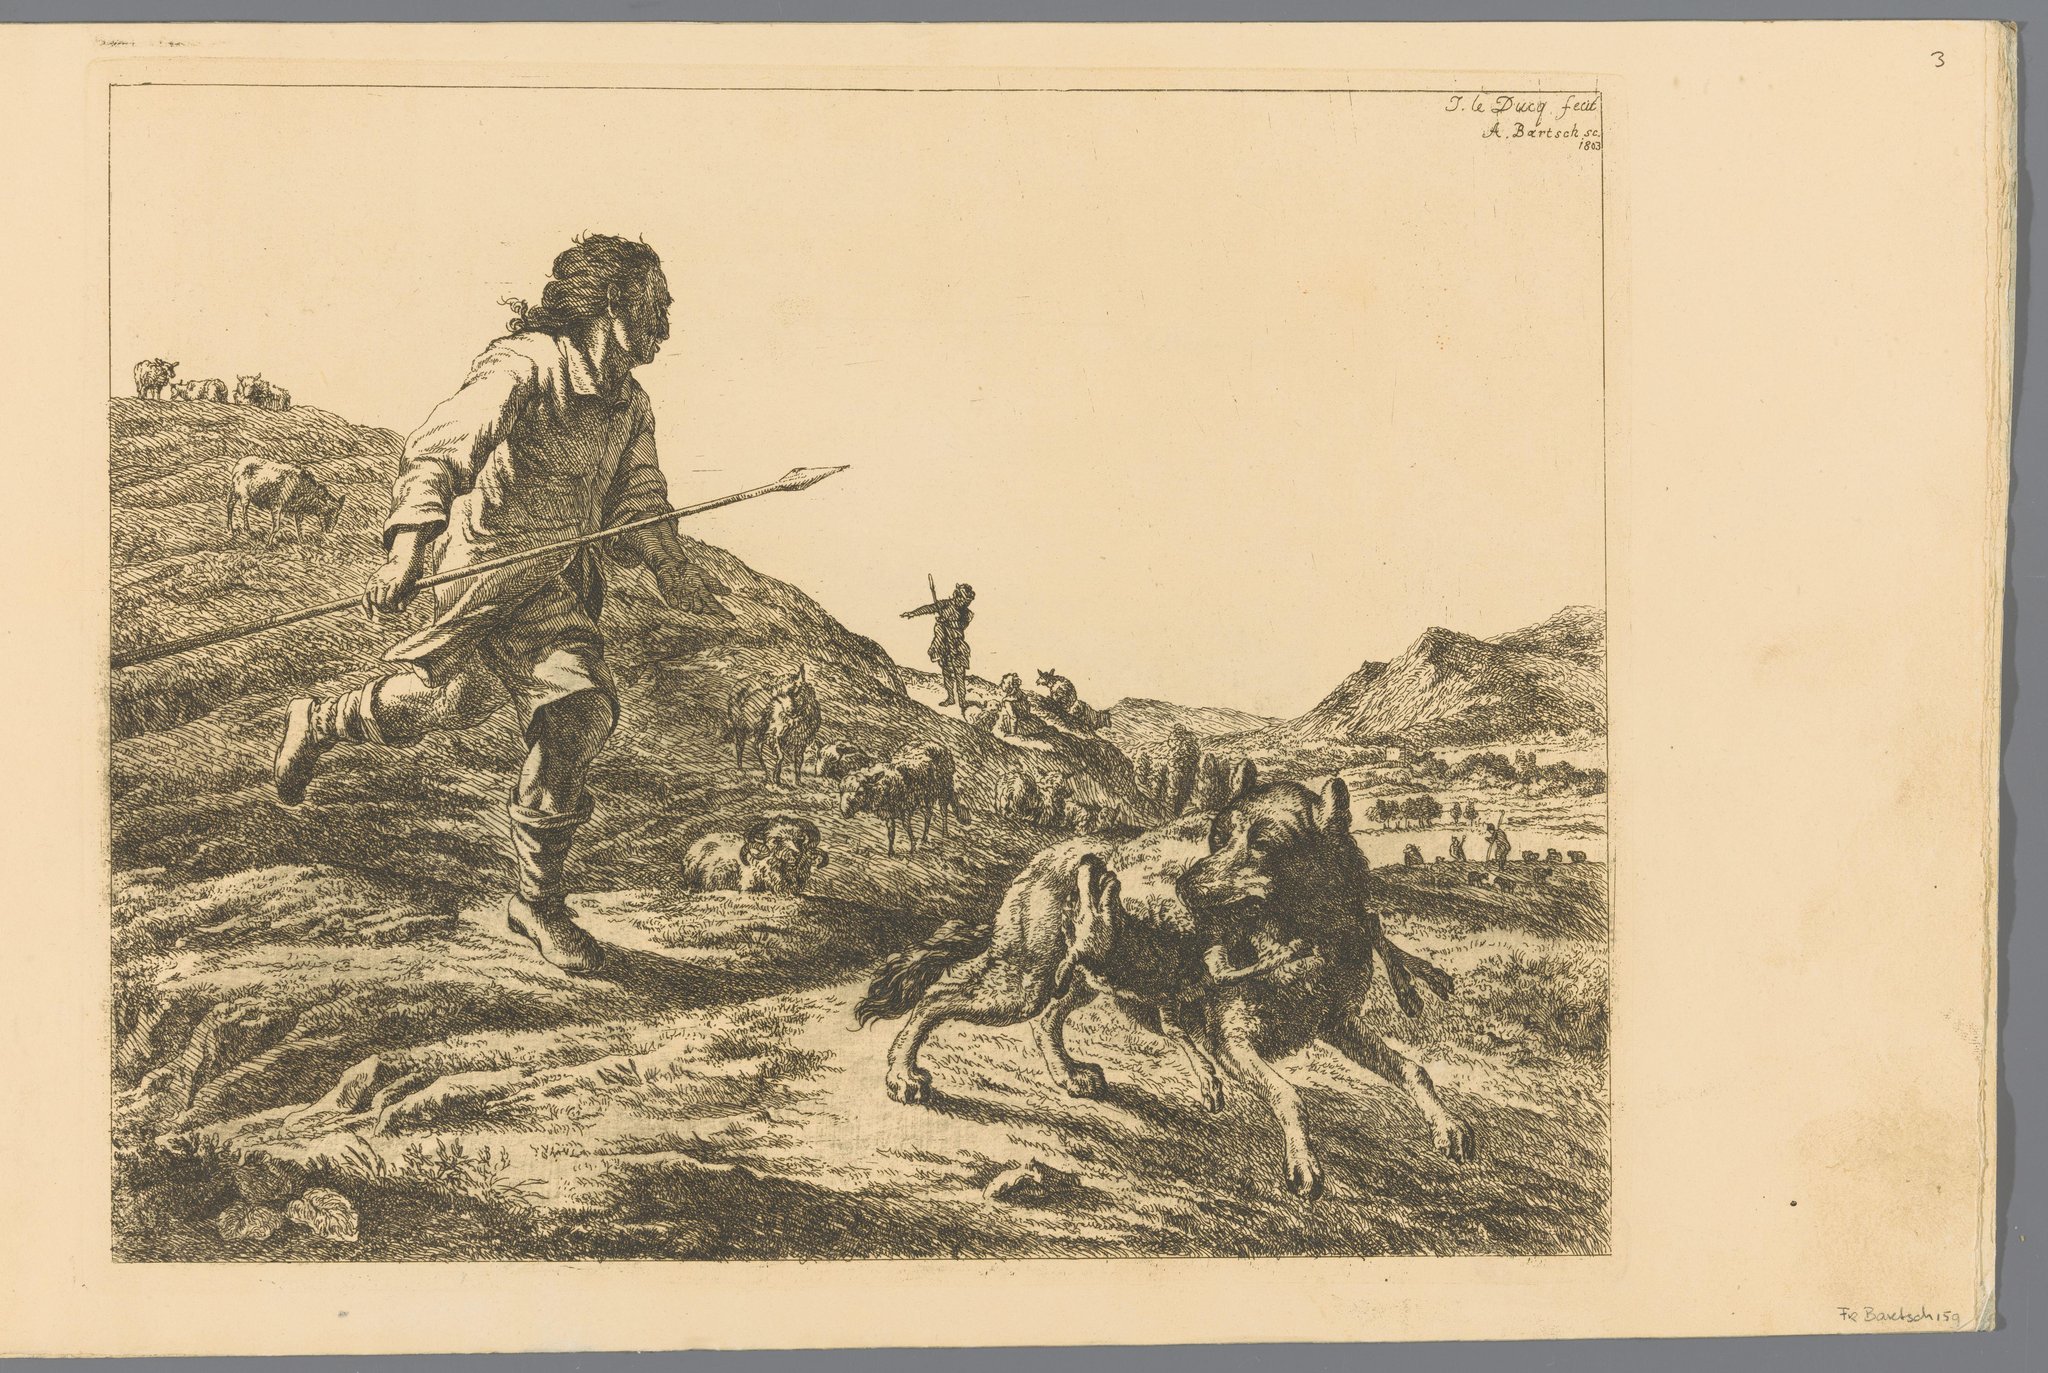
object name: print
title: Herder achtervolgt een wolf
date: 1803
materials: paper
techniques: etching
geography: netherlands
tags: herding, herdsman, herdswoman, shepherd, shepherdess, cowherd, etc., sheep, beasts of prey, predatory animals: wolf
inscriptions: collector's mark: Lugt 12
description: Deze prent maakt deel uit van een album.